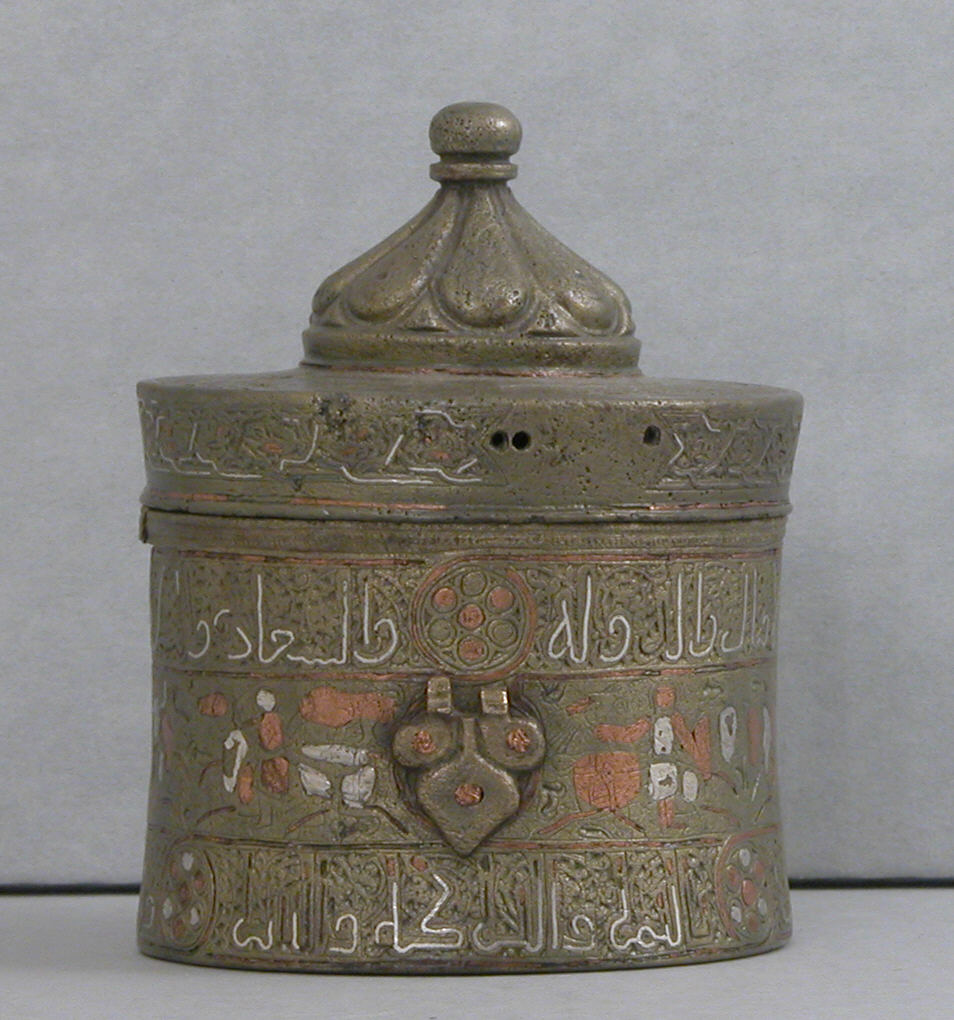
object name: inkwell with cover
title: Box with Lid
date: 1101-1200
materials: bronze, copper, silver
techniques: casting, engraving, inlay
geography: iran or afghanistan